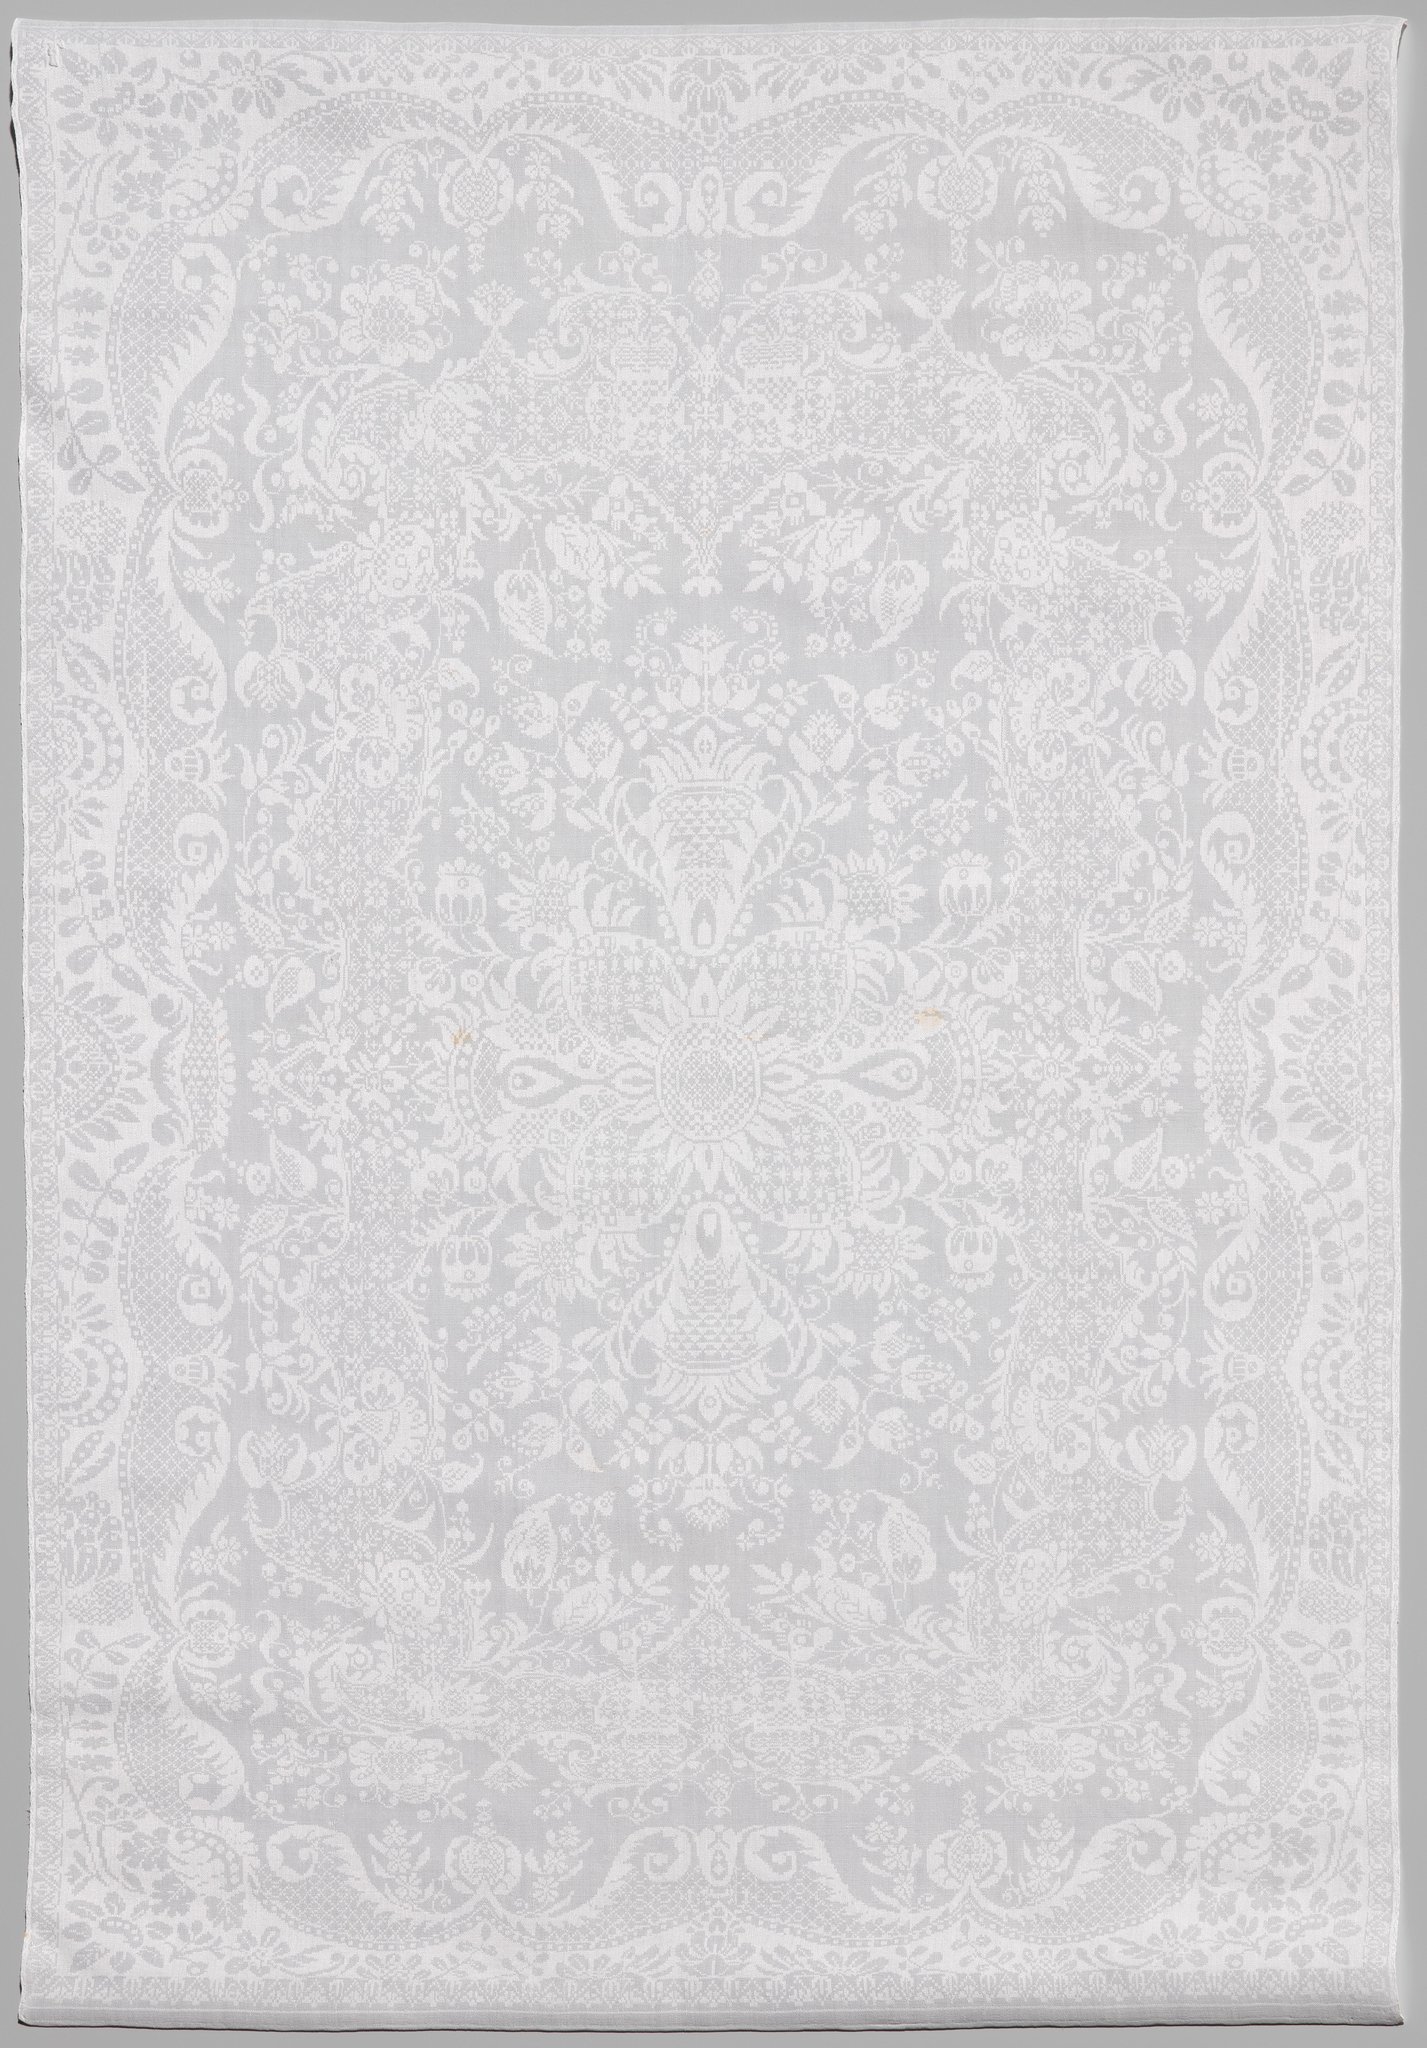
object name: napkin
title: Servet van linnendamast met een bloemen- en kantpatroon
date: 1725-1730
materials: linen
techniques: damask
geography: flanders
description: Wit linnendamasten servet, vlak volledig gevuld met verschillende bloemen, ananas, granaatappels met een slingered kantpatroon. Met geborduurd monogram: T.